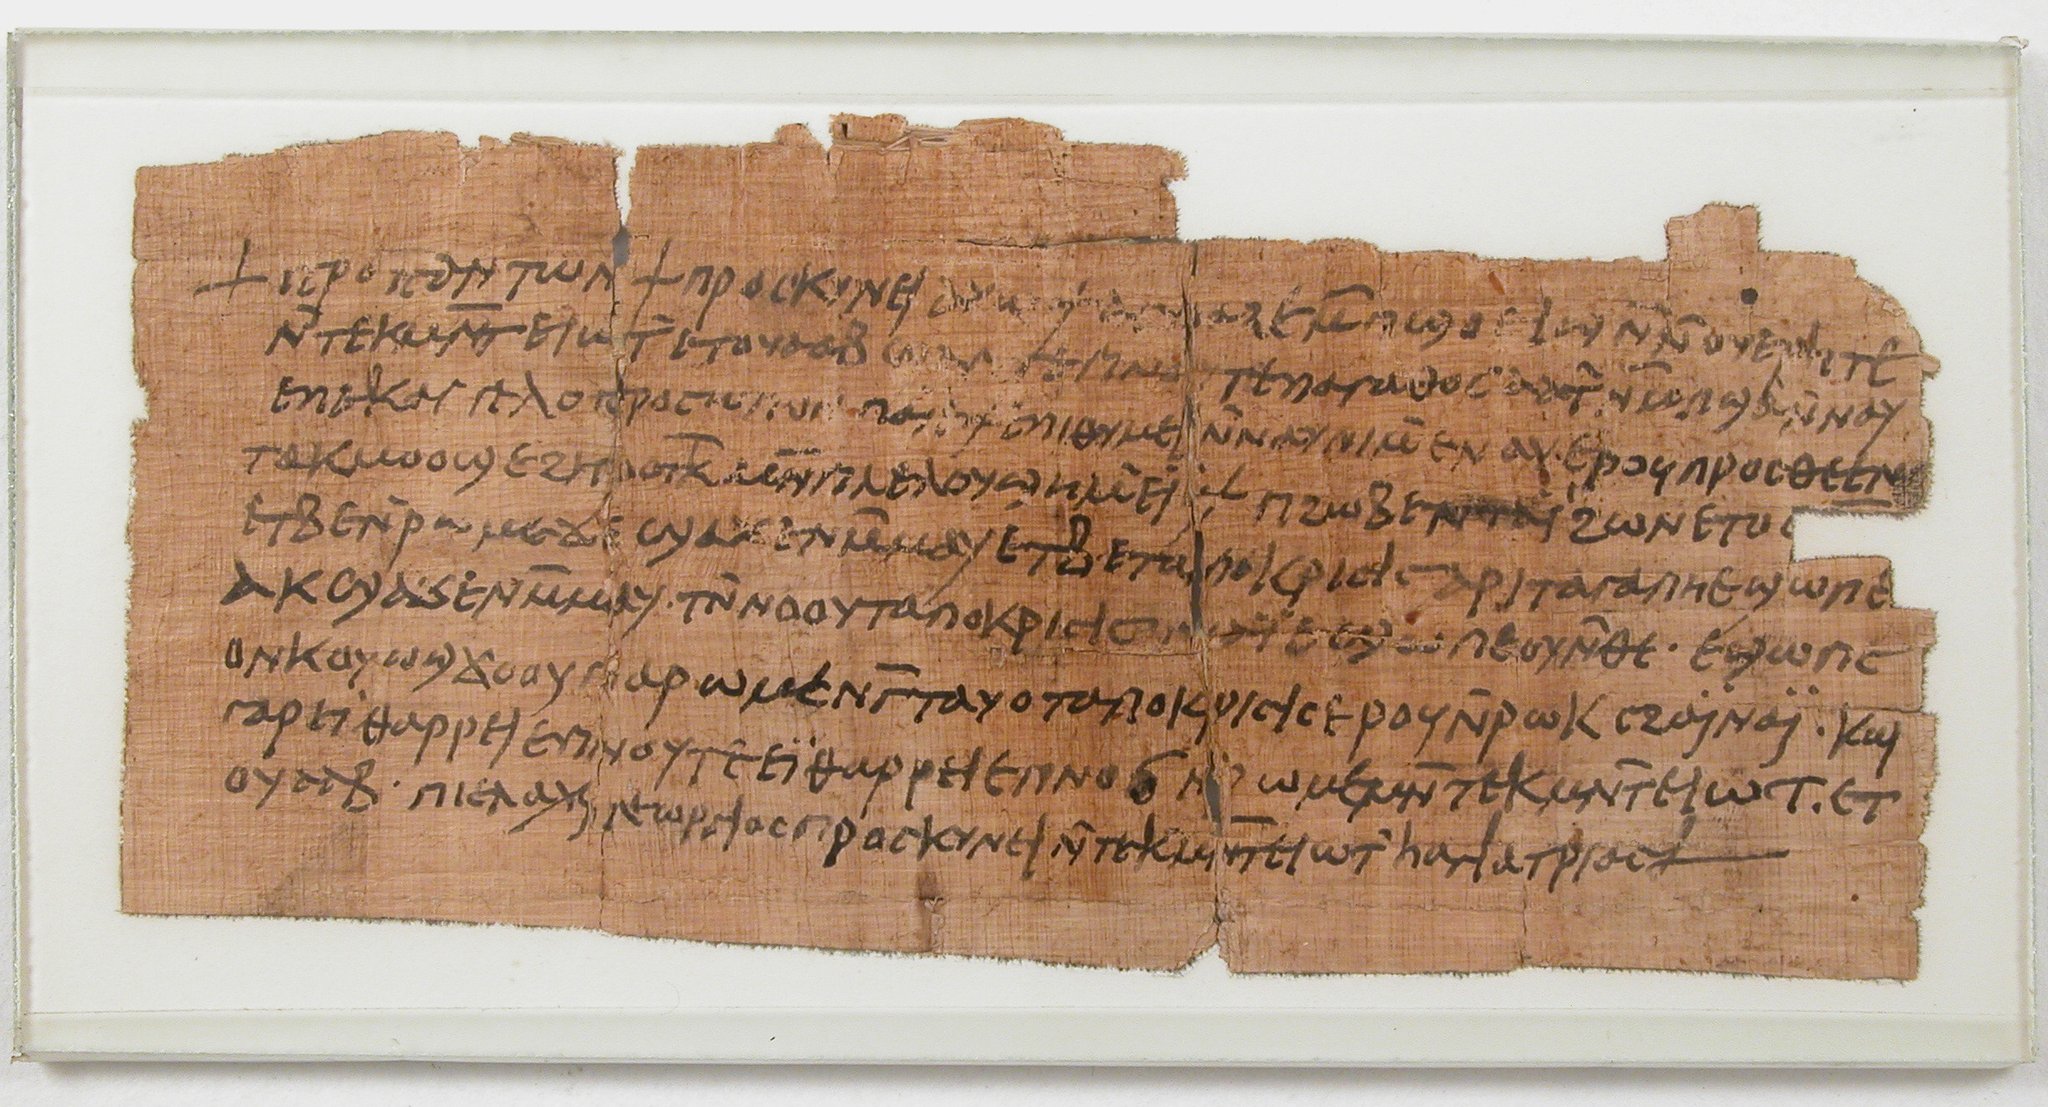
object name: fragment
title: Papyrus Fragment of a Letter from Victor to Psan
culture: coptic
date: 580-640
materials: ink, papyrus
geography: egypt